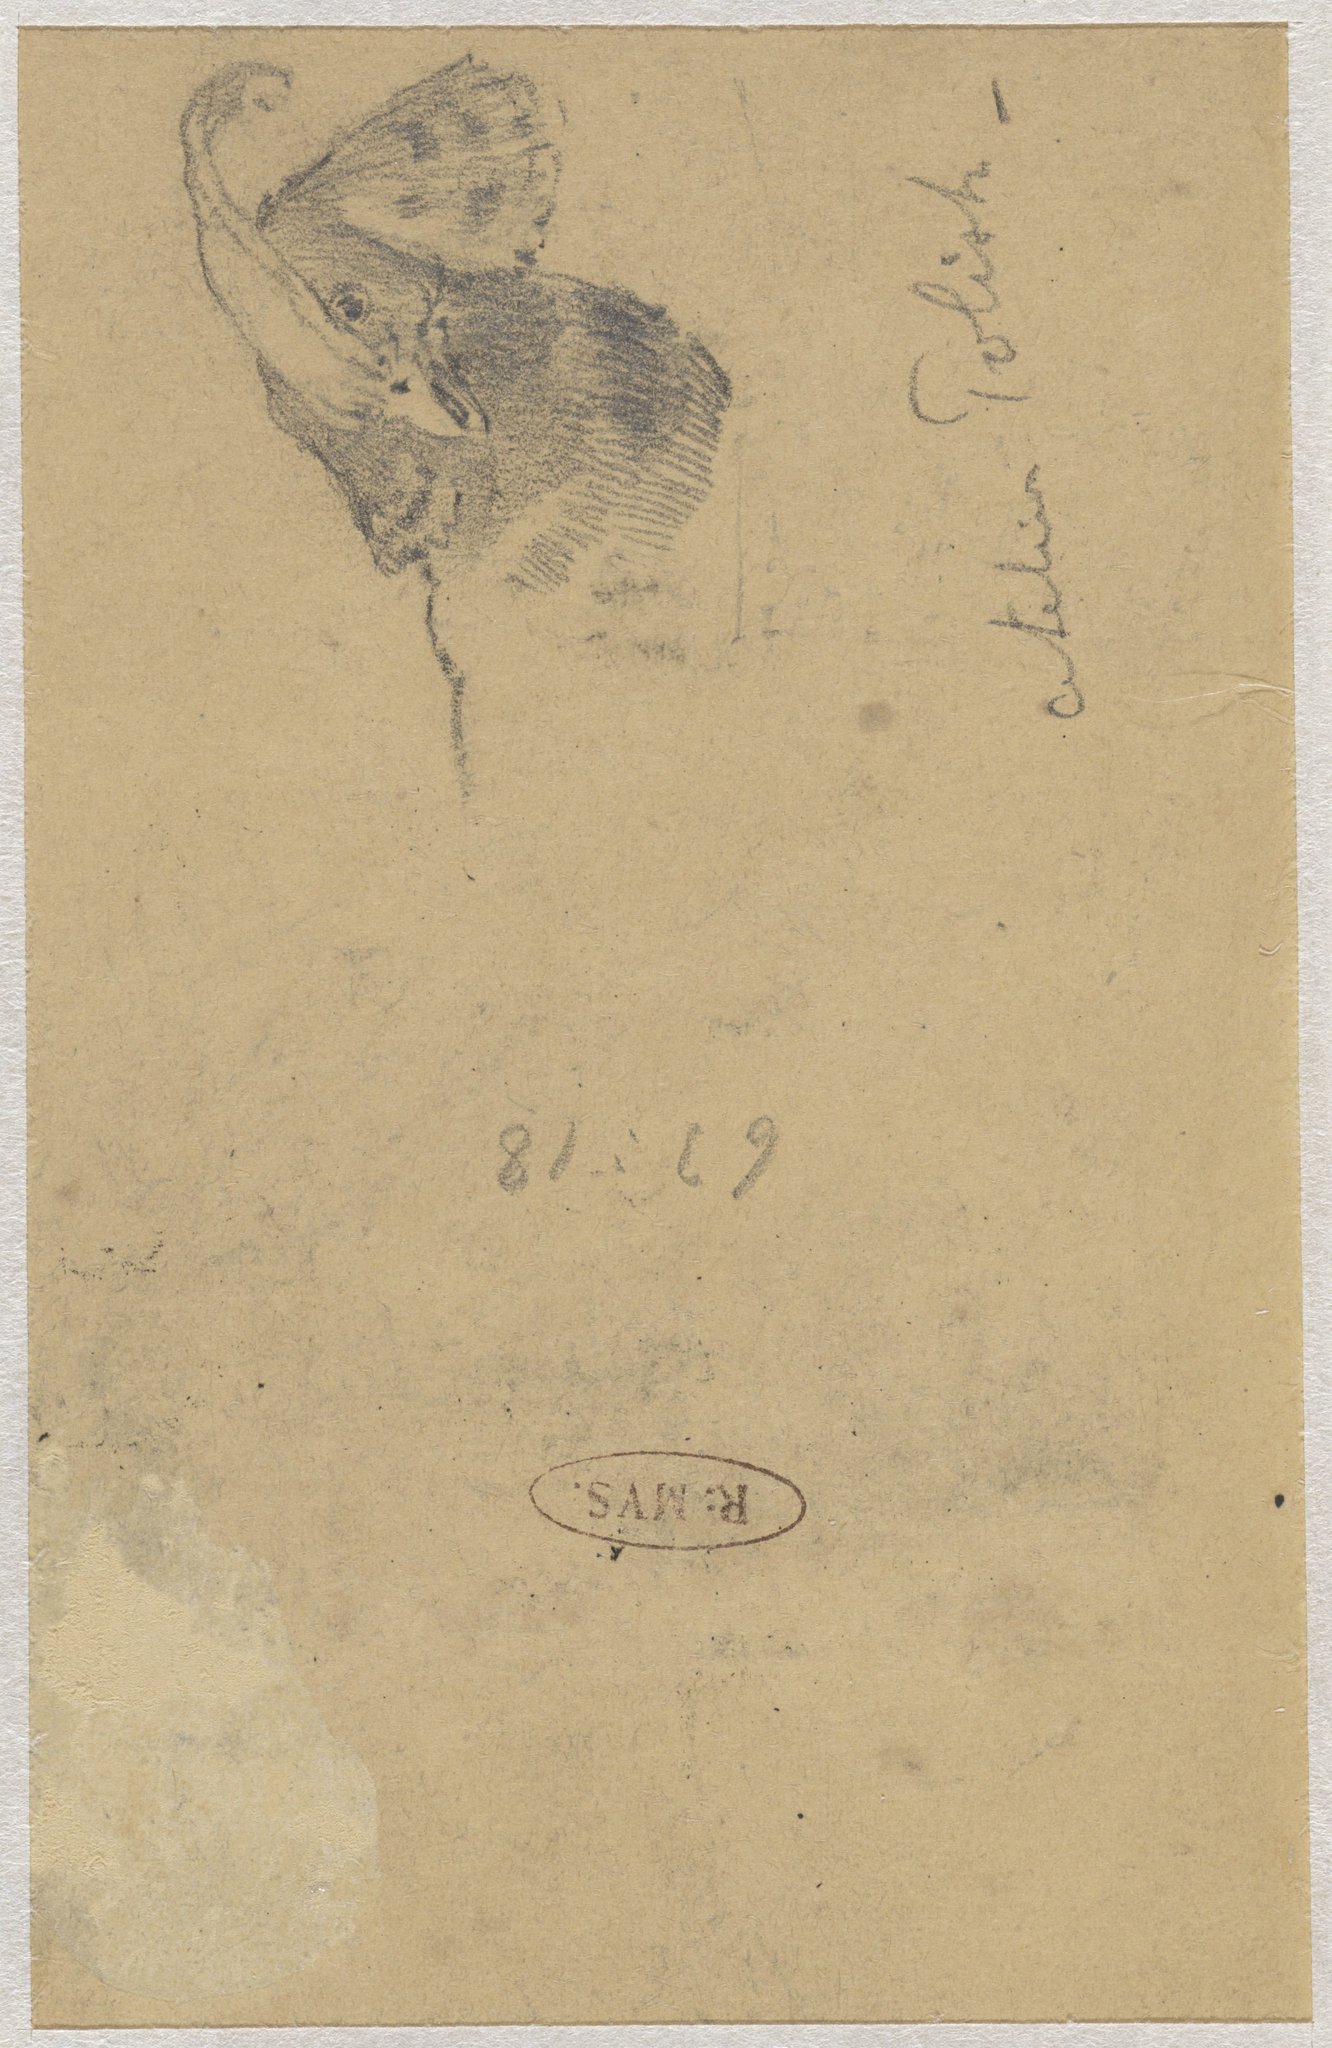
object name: drawing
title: Vogelkop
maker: adolf le comte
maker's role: draughtsman, painter, print maker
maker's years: 1850-1921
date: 1860-1921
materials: paper, pencil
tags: birds